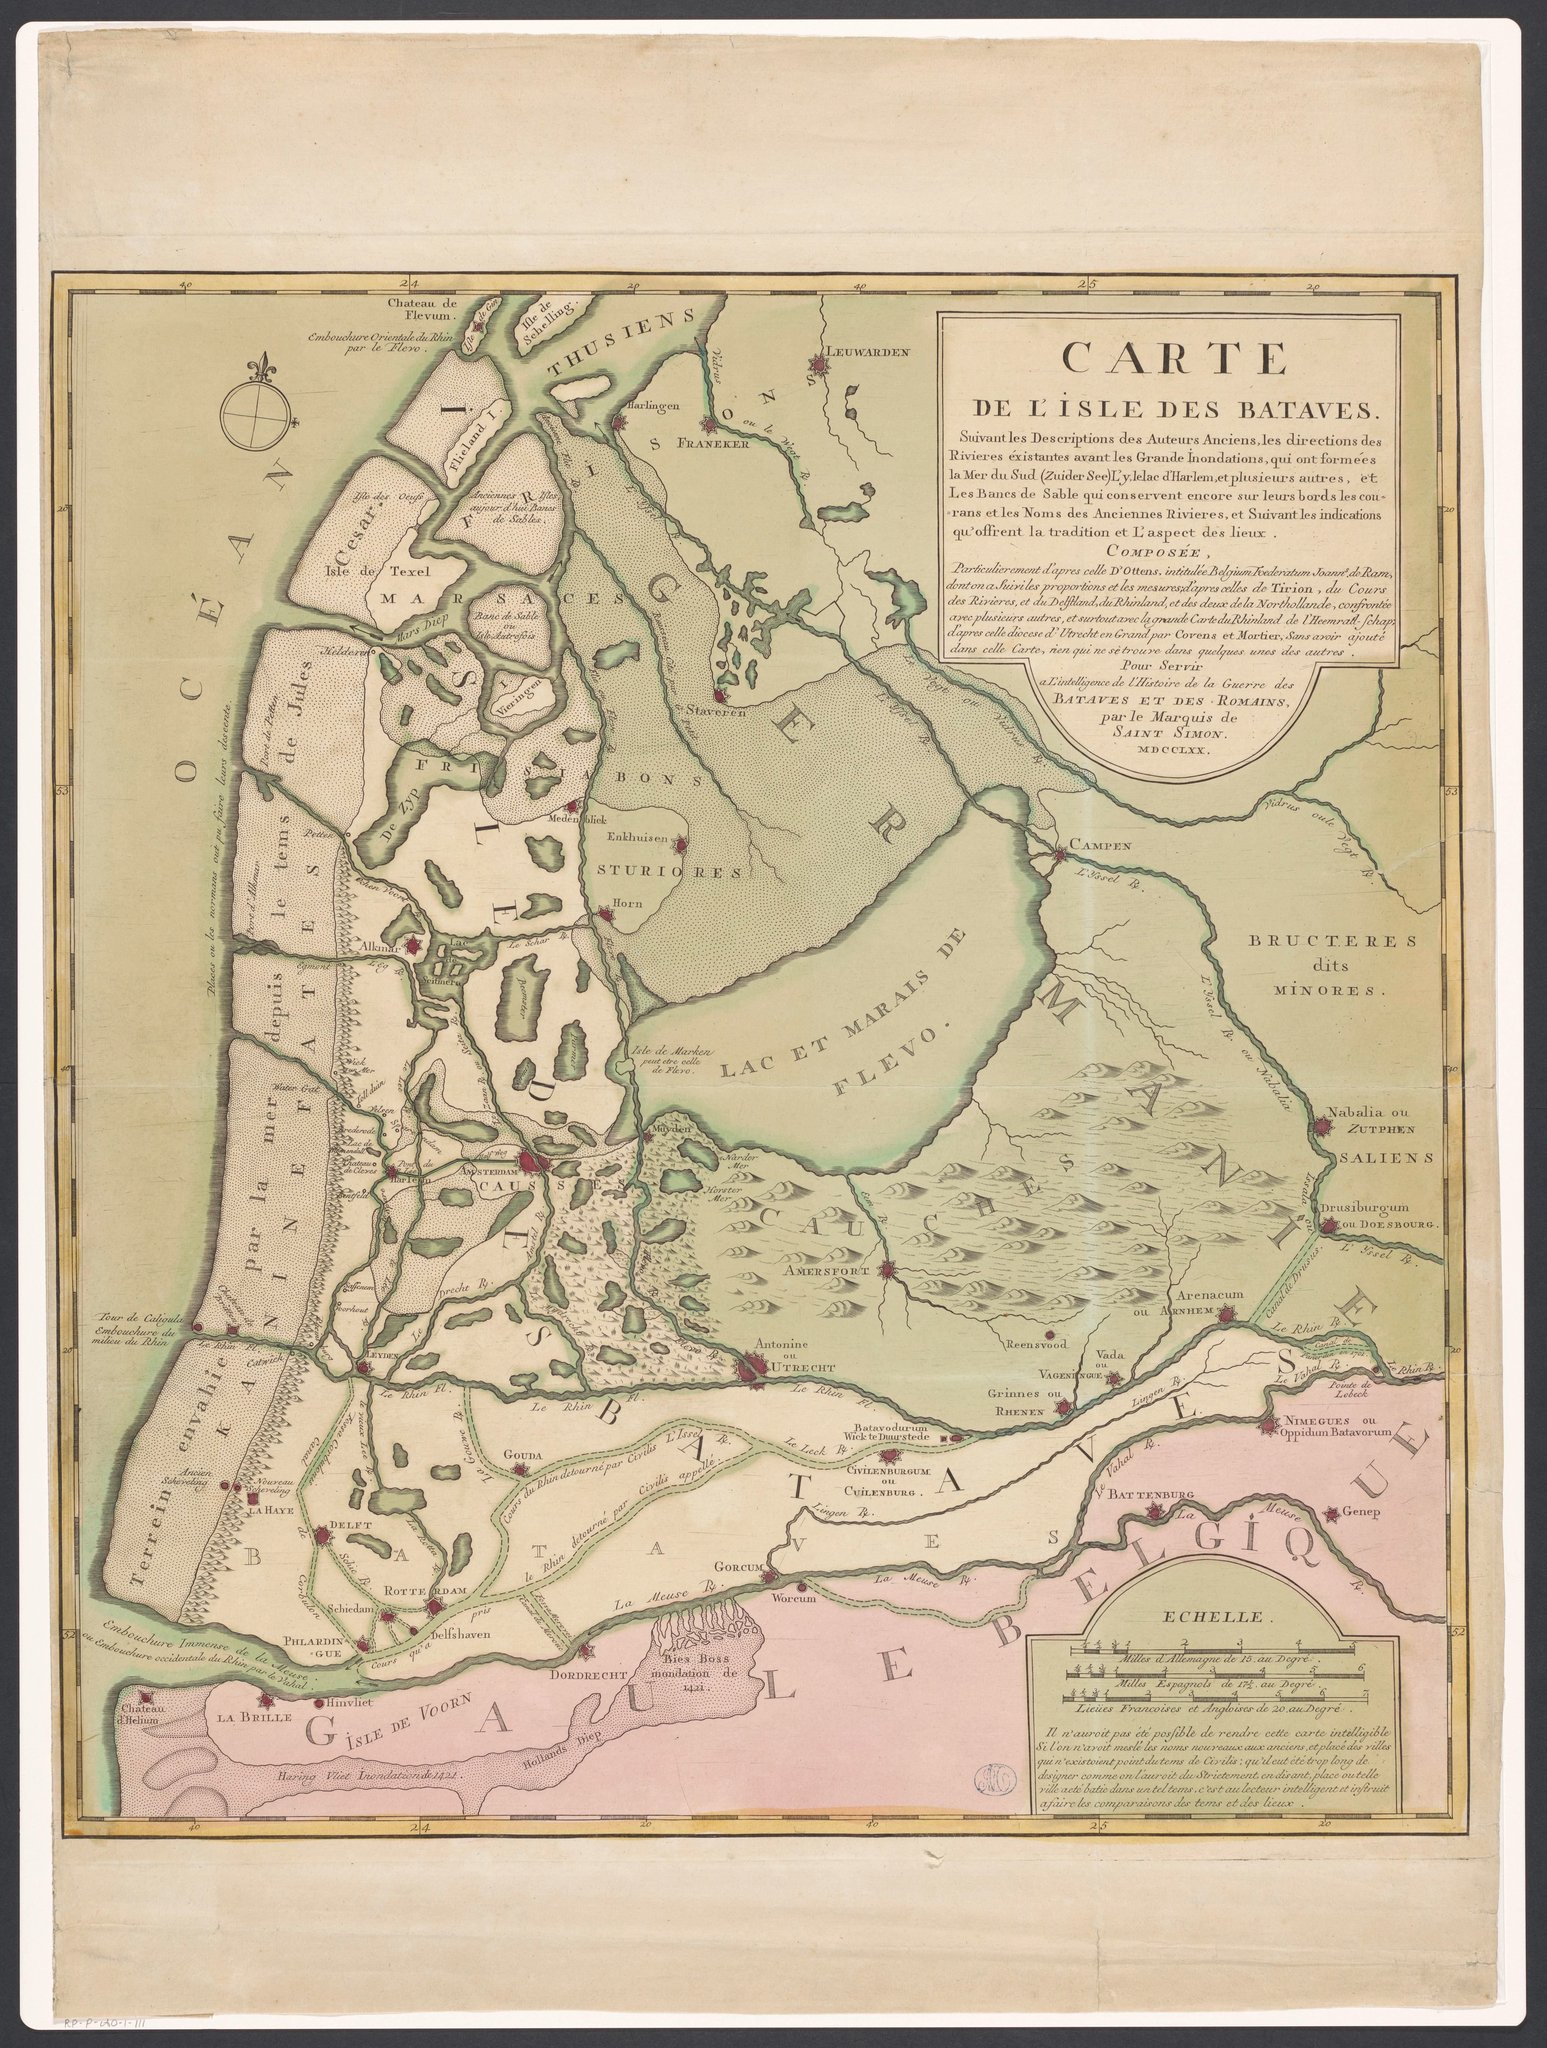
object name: print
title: Carte de l'isle des Bataves (...)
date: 1770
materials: paper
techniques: engraving, hand coloring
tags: maps of separate countries or regions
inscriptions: collector's mark: Lugt 2228, collector's mark: Lugt 195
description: Deze kaart behoort tot een serie prenten over de Bataafse Opstand, gekopieerd naar de reeks Batavorum cum Romanis bellum van Antonio Tempesta (Otto Vaenius, Antwerpen 1612) en gebruikt in: Saint-Simon, Maximilien Henri marquis de. Histoire de la guerre des Bataves et des Romains, d'après César, Corneille Tacite &c. Amsterdam: Marc Michel Rey, 1770.